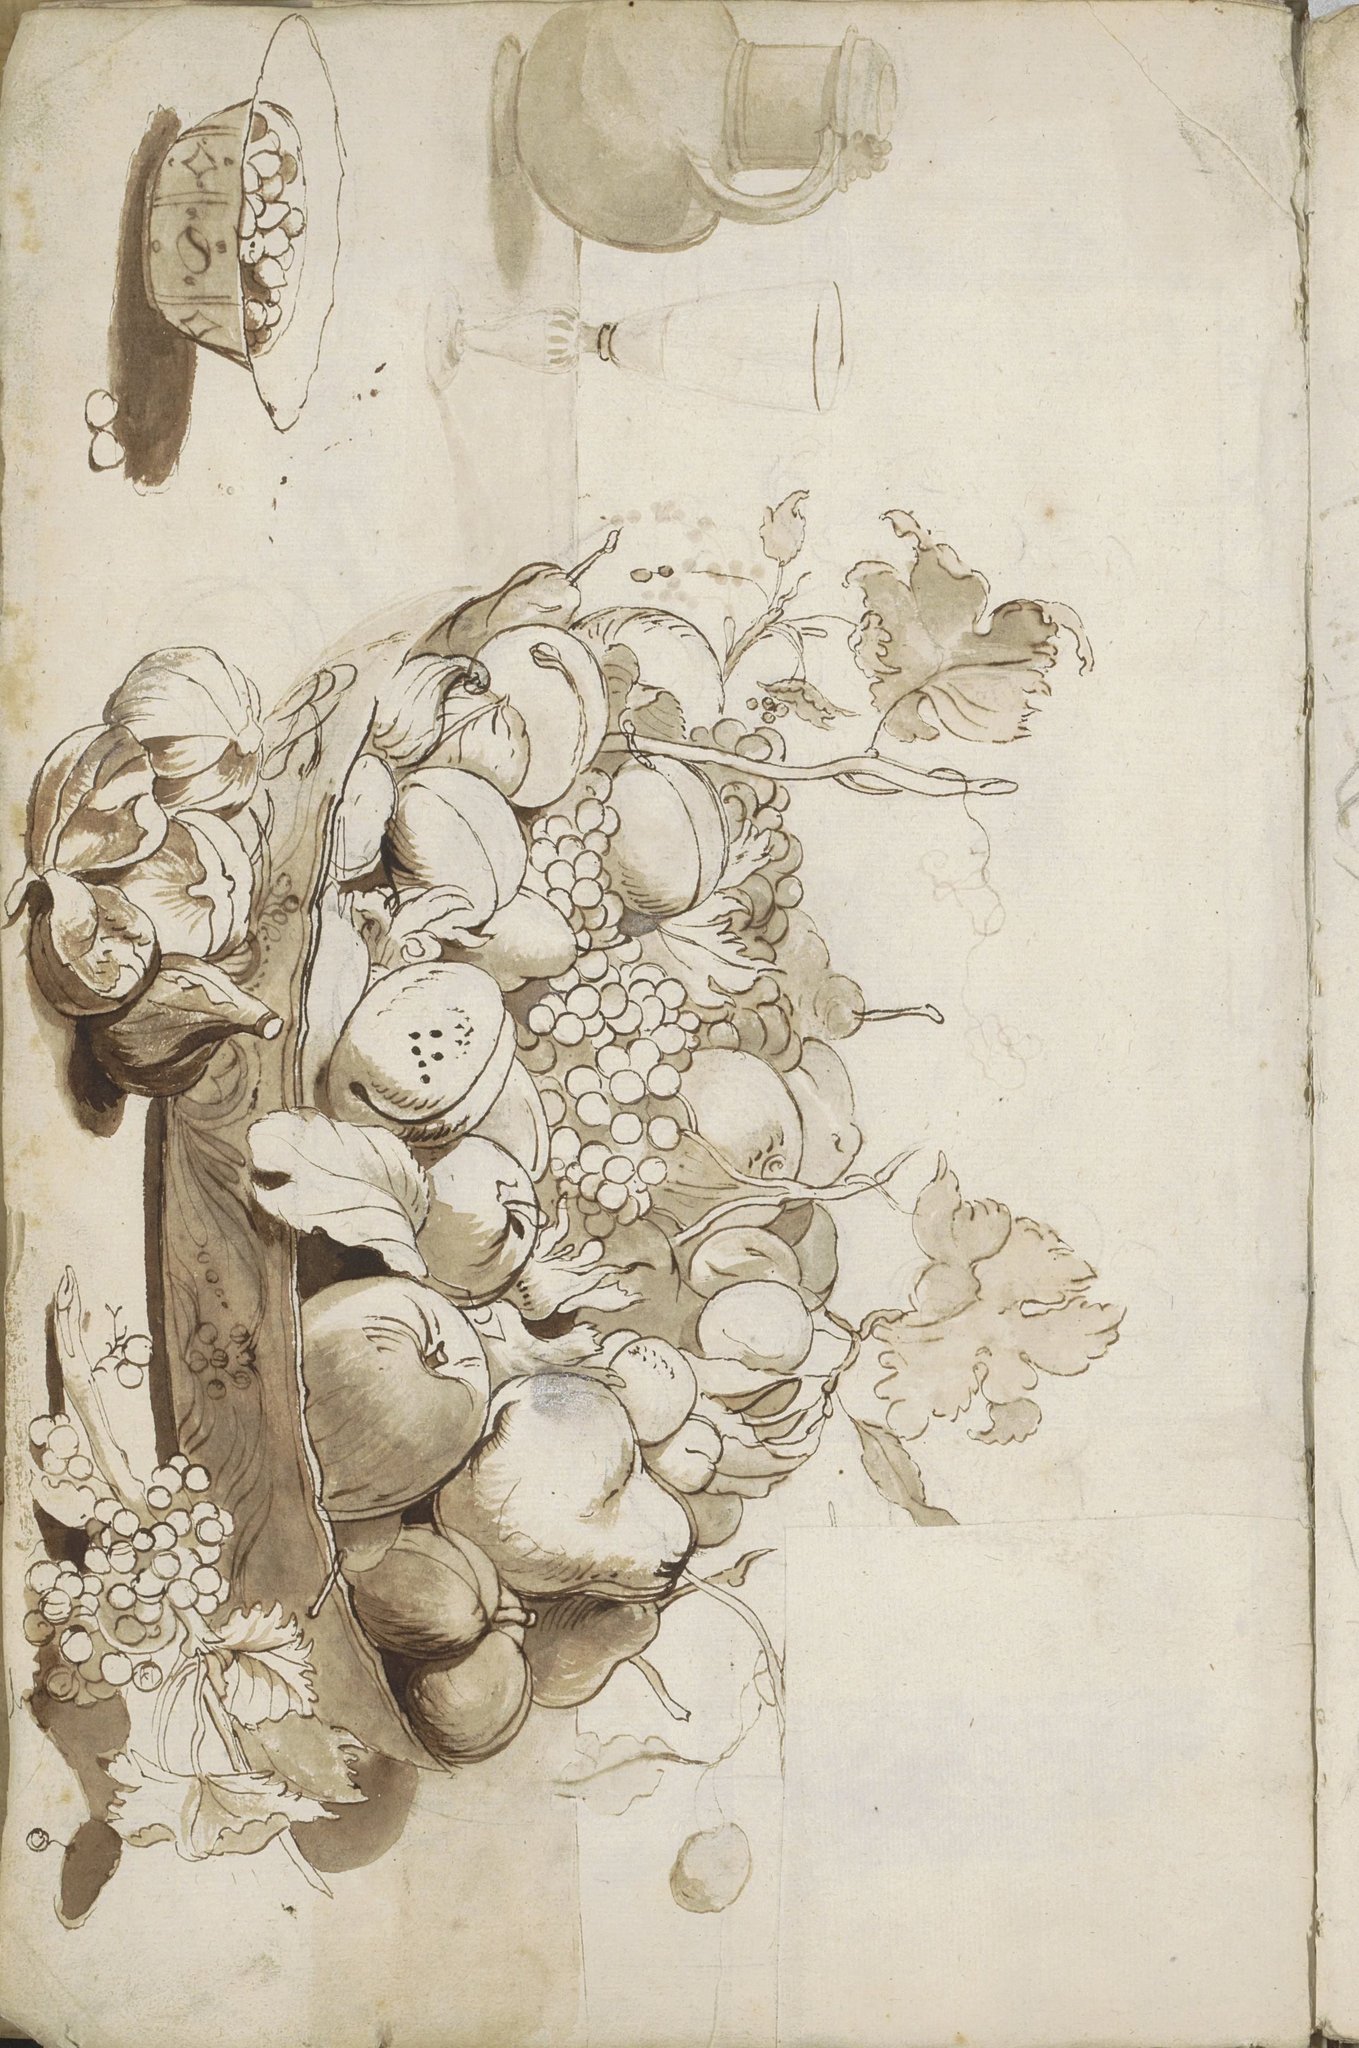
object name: sketchbook leaf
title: Stilleven met fruitmand, een kan en uien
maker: paul de vos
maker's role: draughtsman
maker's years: 1595-1678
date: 1605-1678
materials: ink, paper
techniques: brush, pen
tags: still life of related objects, container of ceramics: jar, jug, pot, vase, fruits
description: Blad 3 verso uit een schetsboek met 15 bladen.